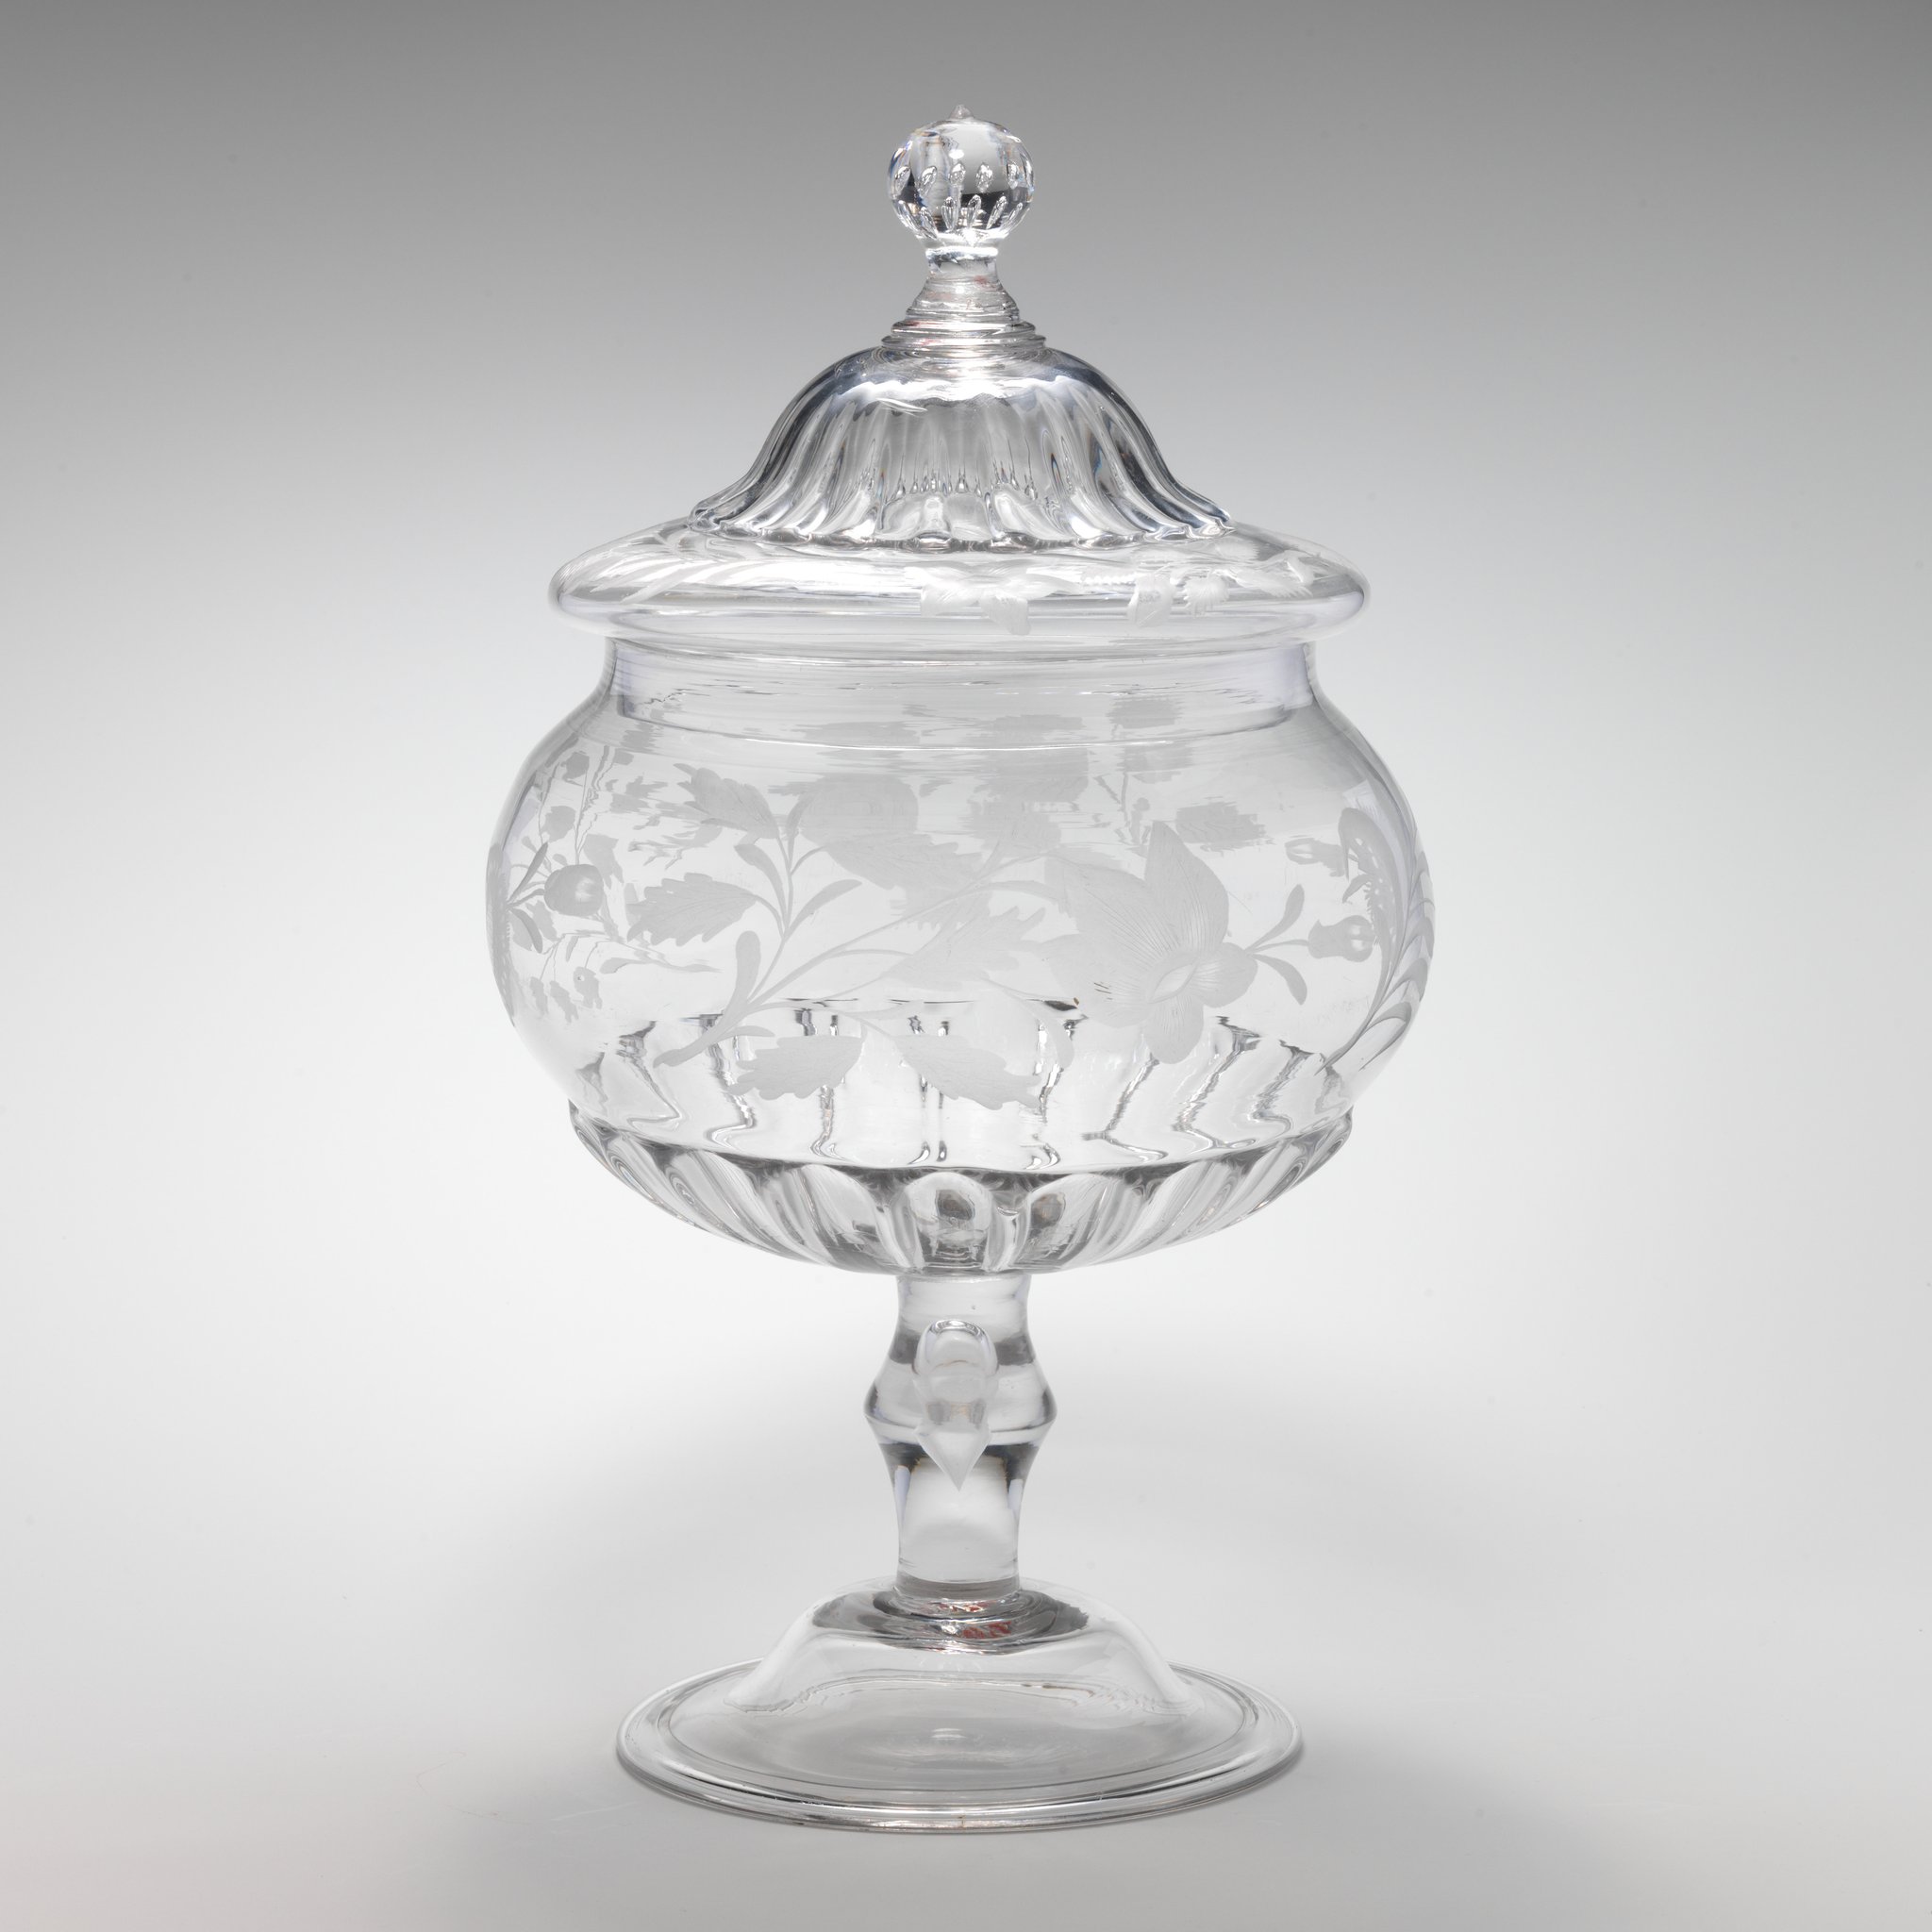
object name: sweetmeat glass with cover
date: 1750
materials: glass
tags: flowers